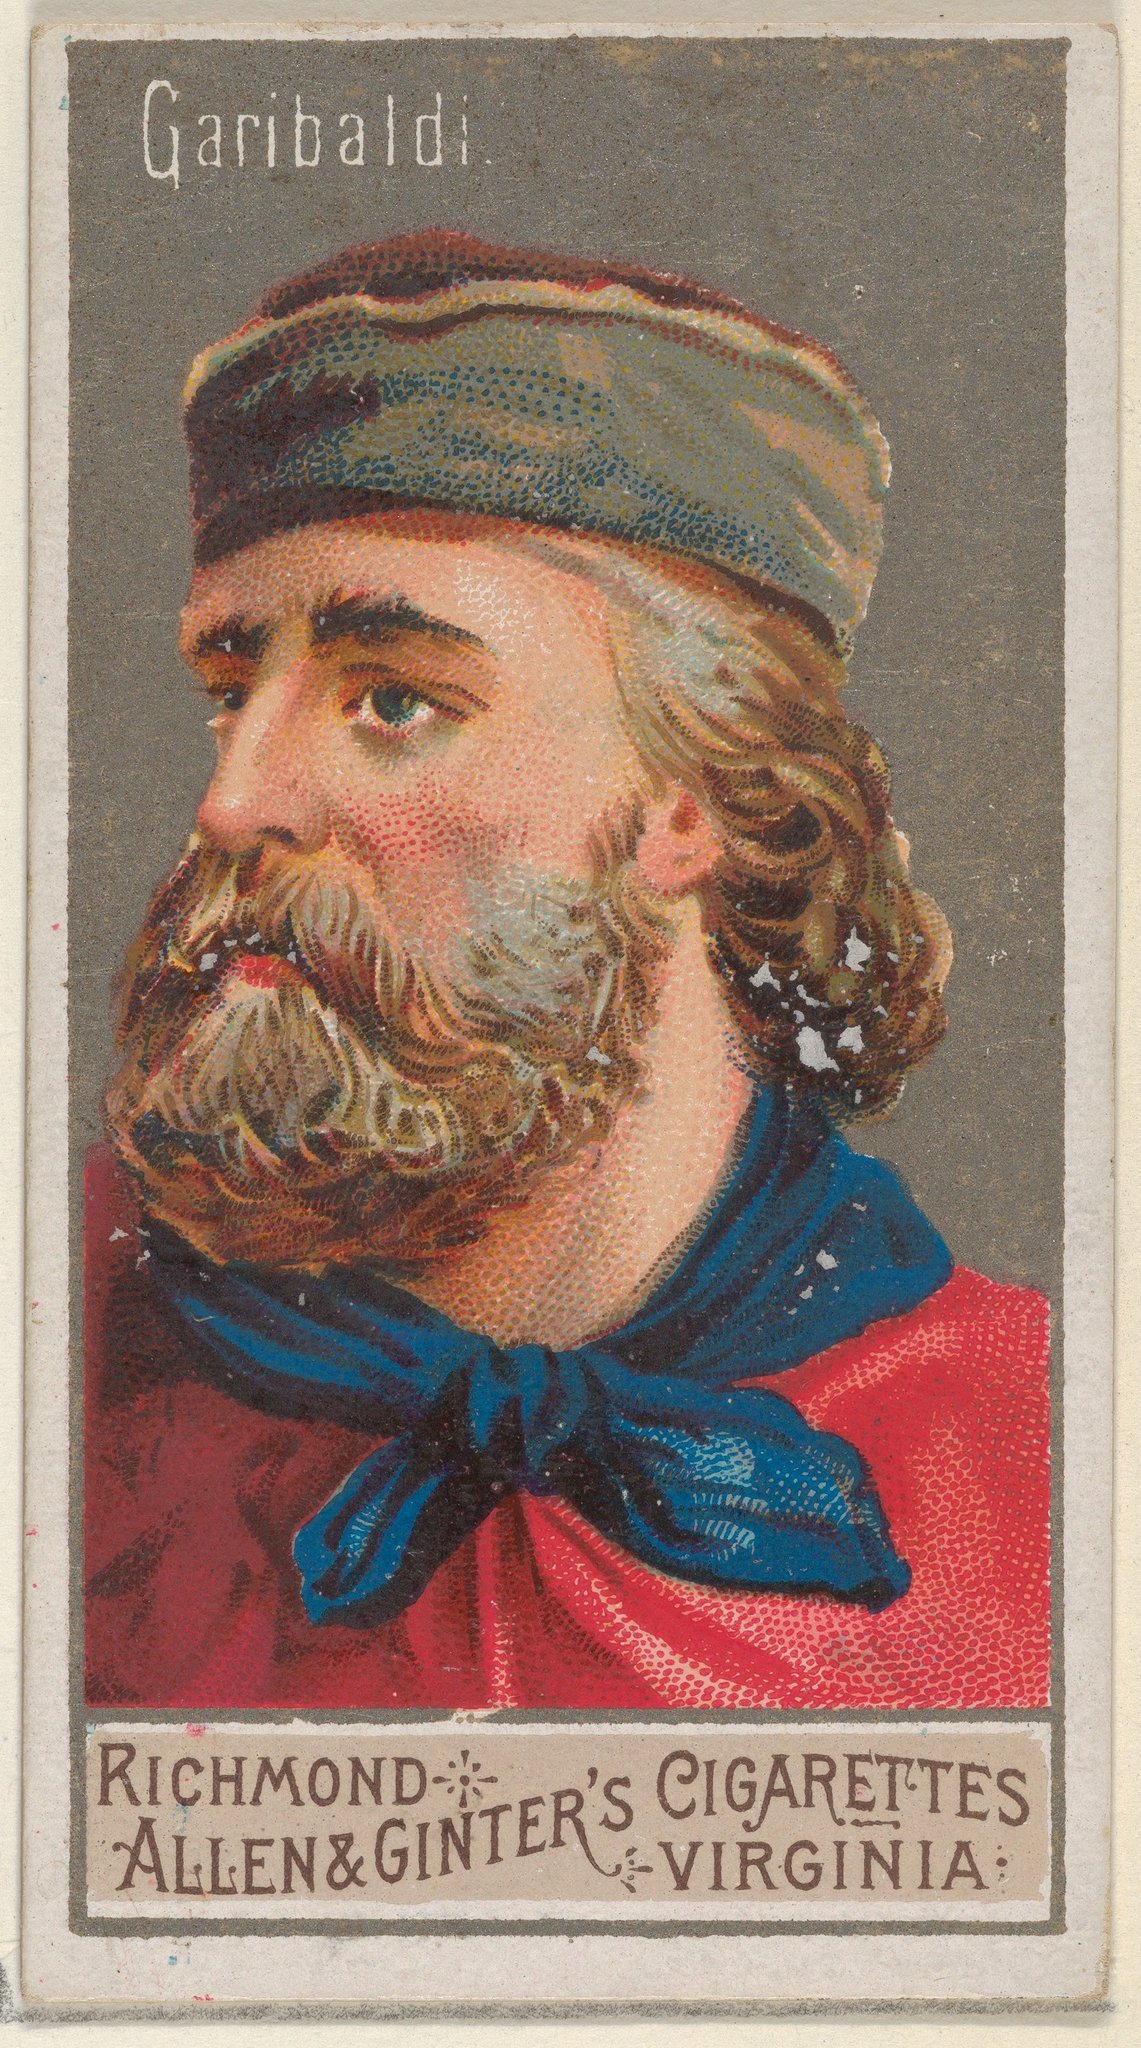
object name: print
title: Giuseppe Garibaldi, from the Great Generals series (N15) for Allen & Ginter Cigarettes Brands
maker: allen & ginter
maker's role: publisher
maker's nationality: american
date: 1888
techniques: color lithograph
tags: historical figures,men,generals